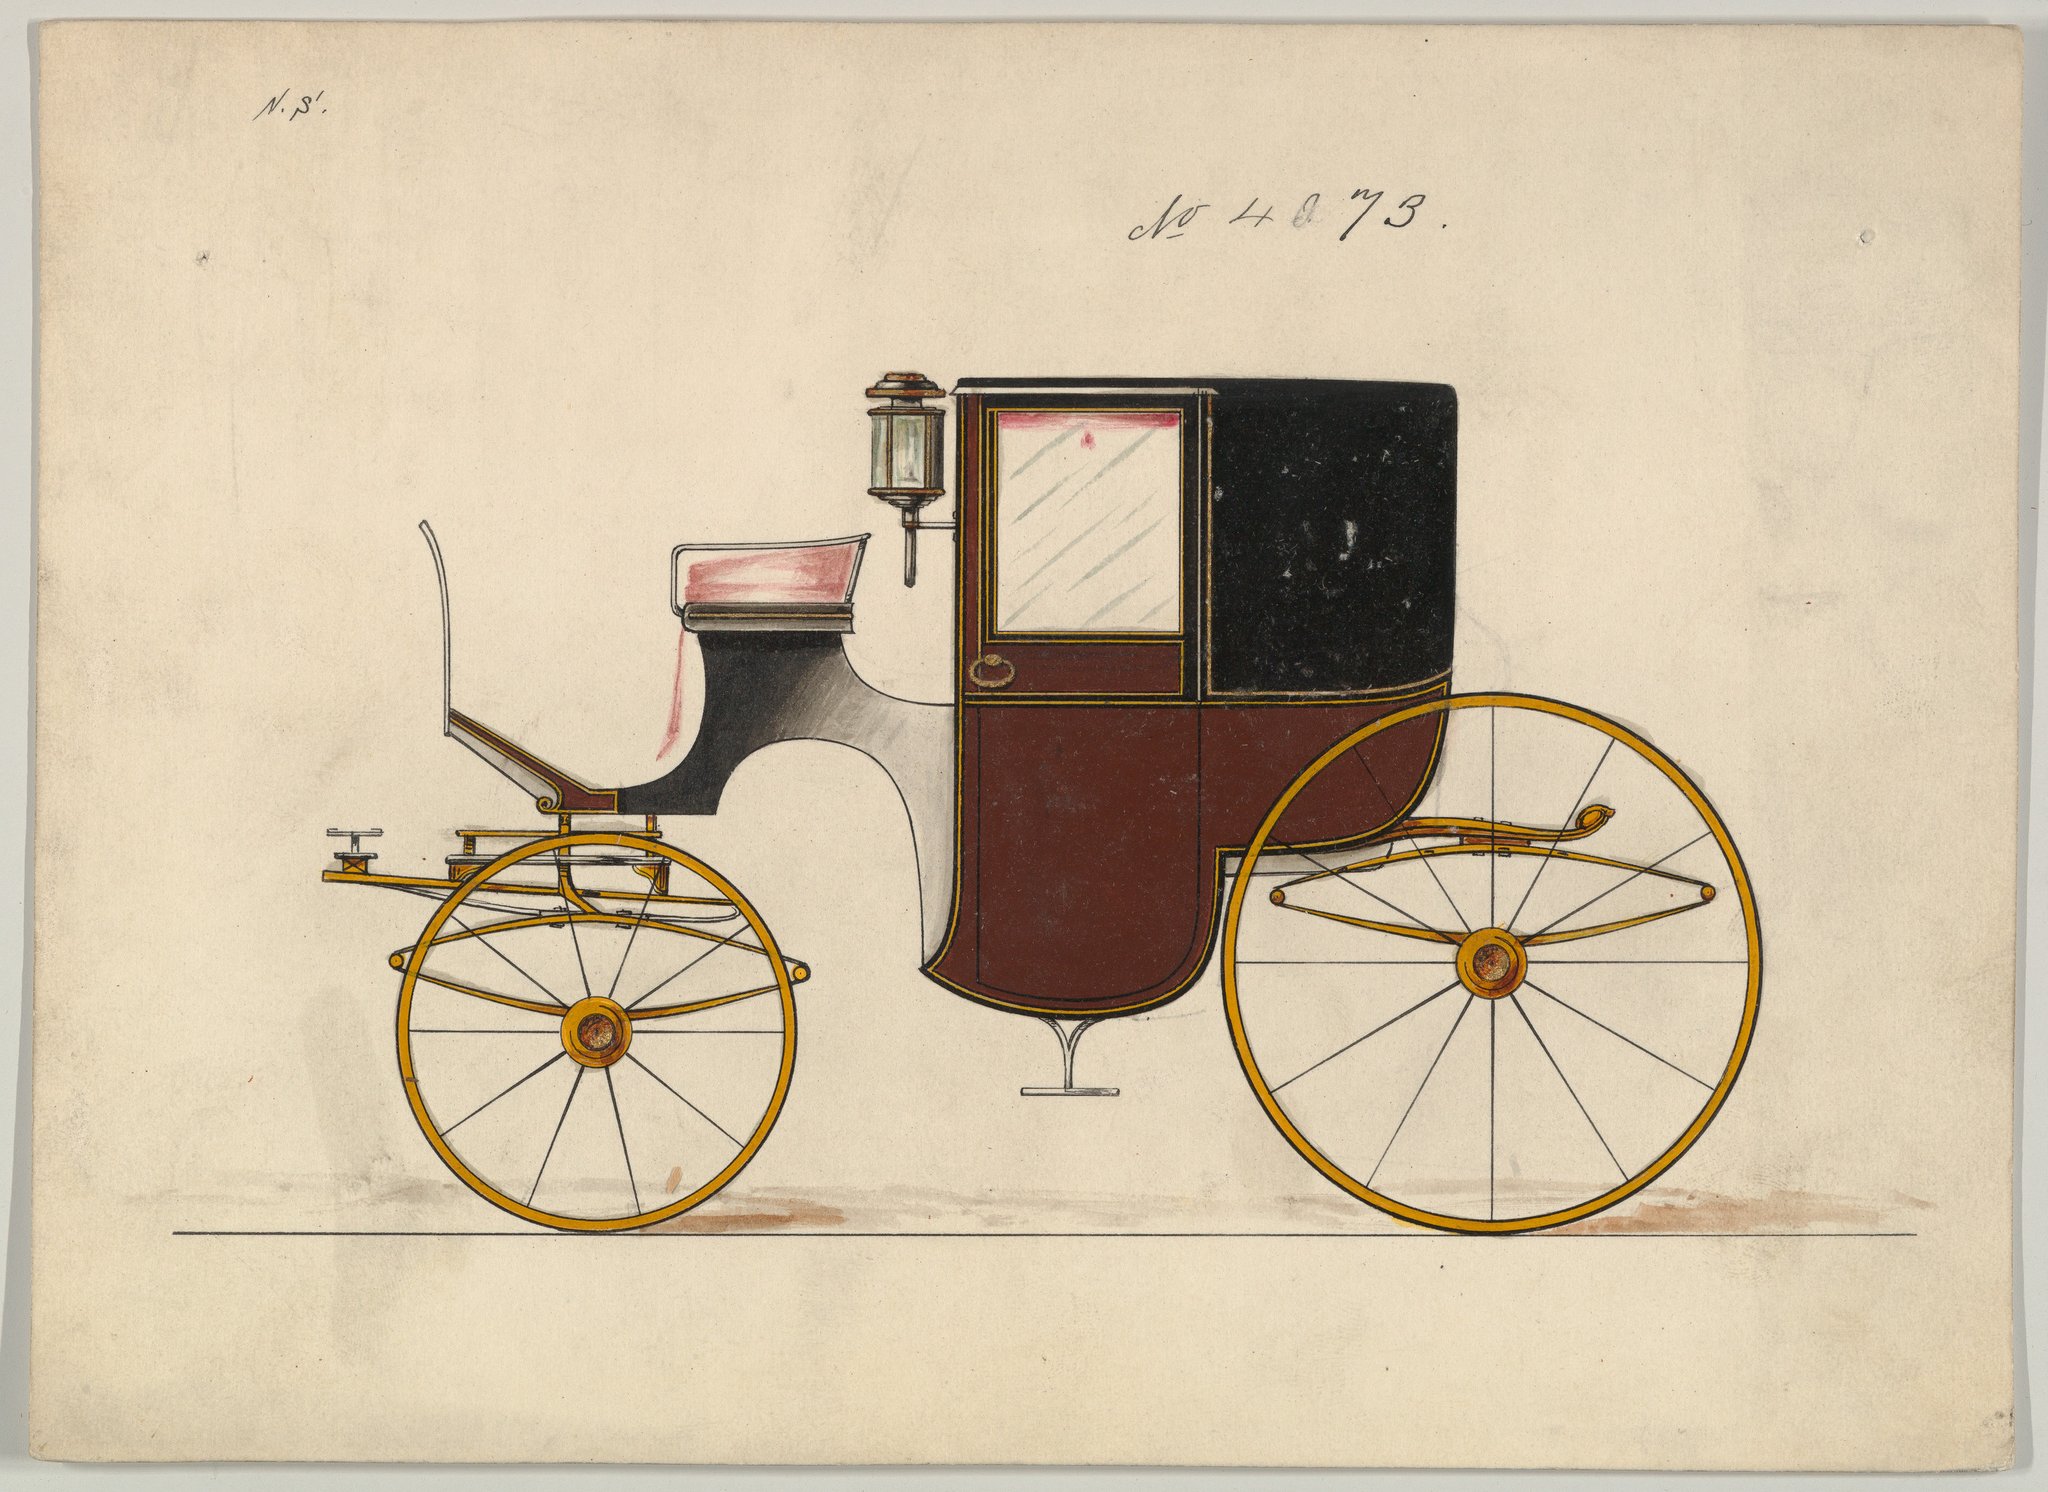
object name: drawing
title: Brougham #4073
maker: brewster & co.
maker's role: manufacturer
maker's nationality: american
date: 1890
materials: gouache, gum arabic, ink, watercolor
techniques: pen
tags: carriages